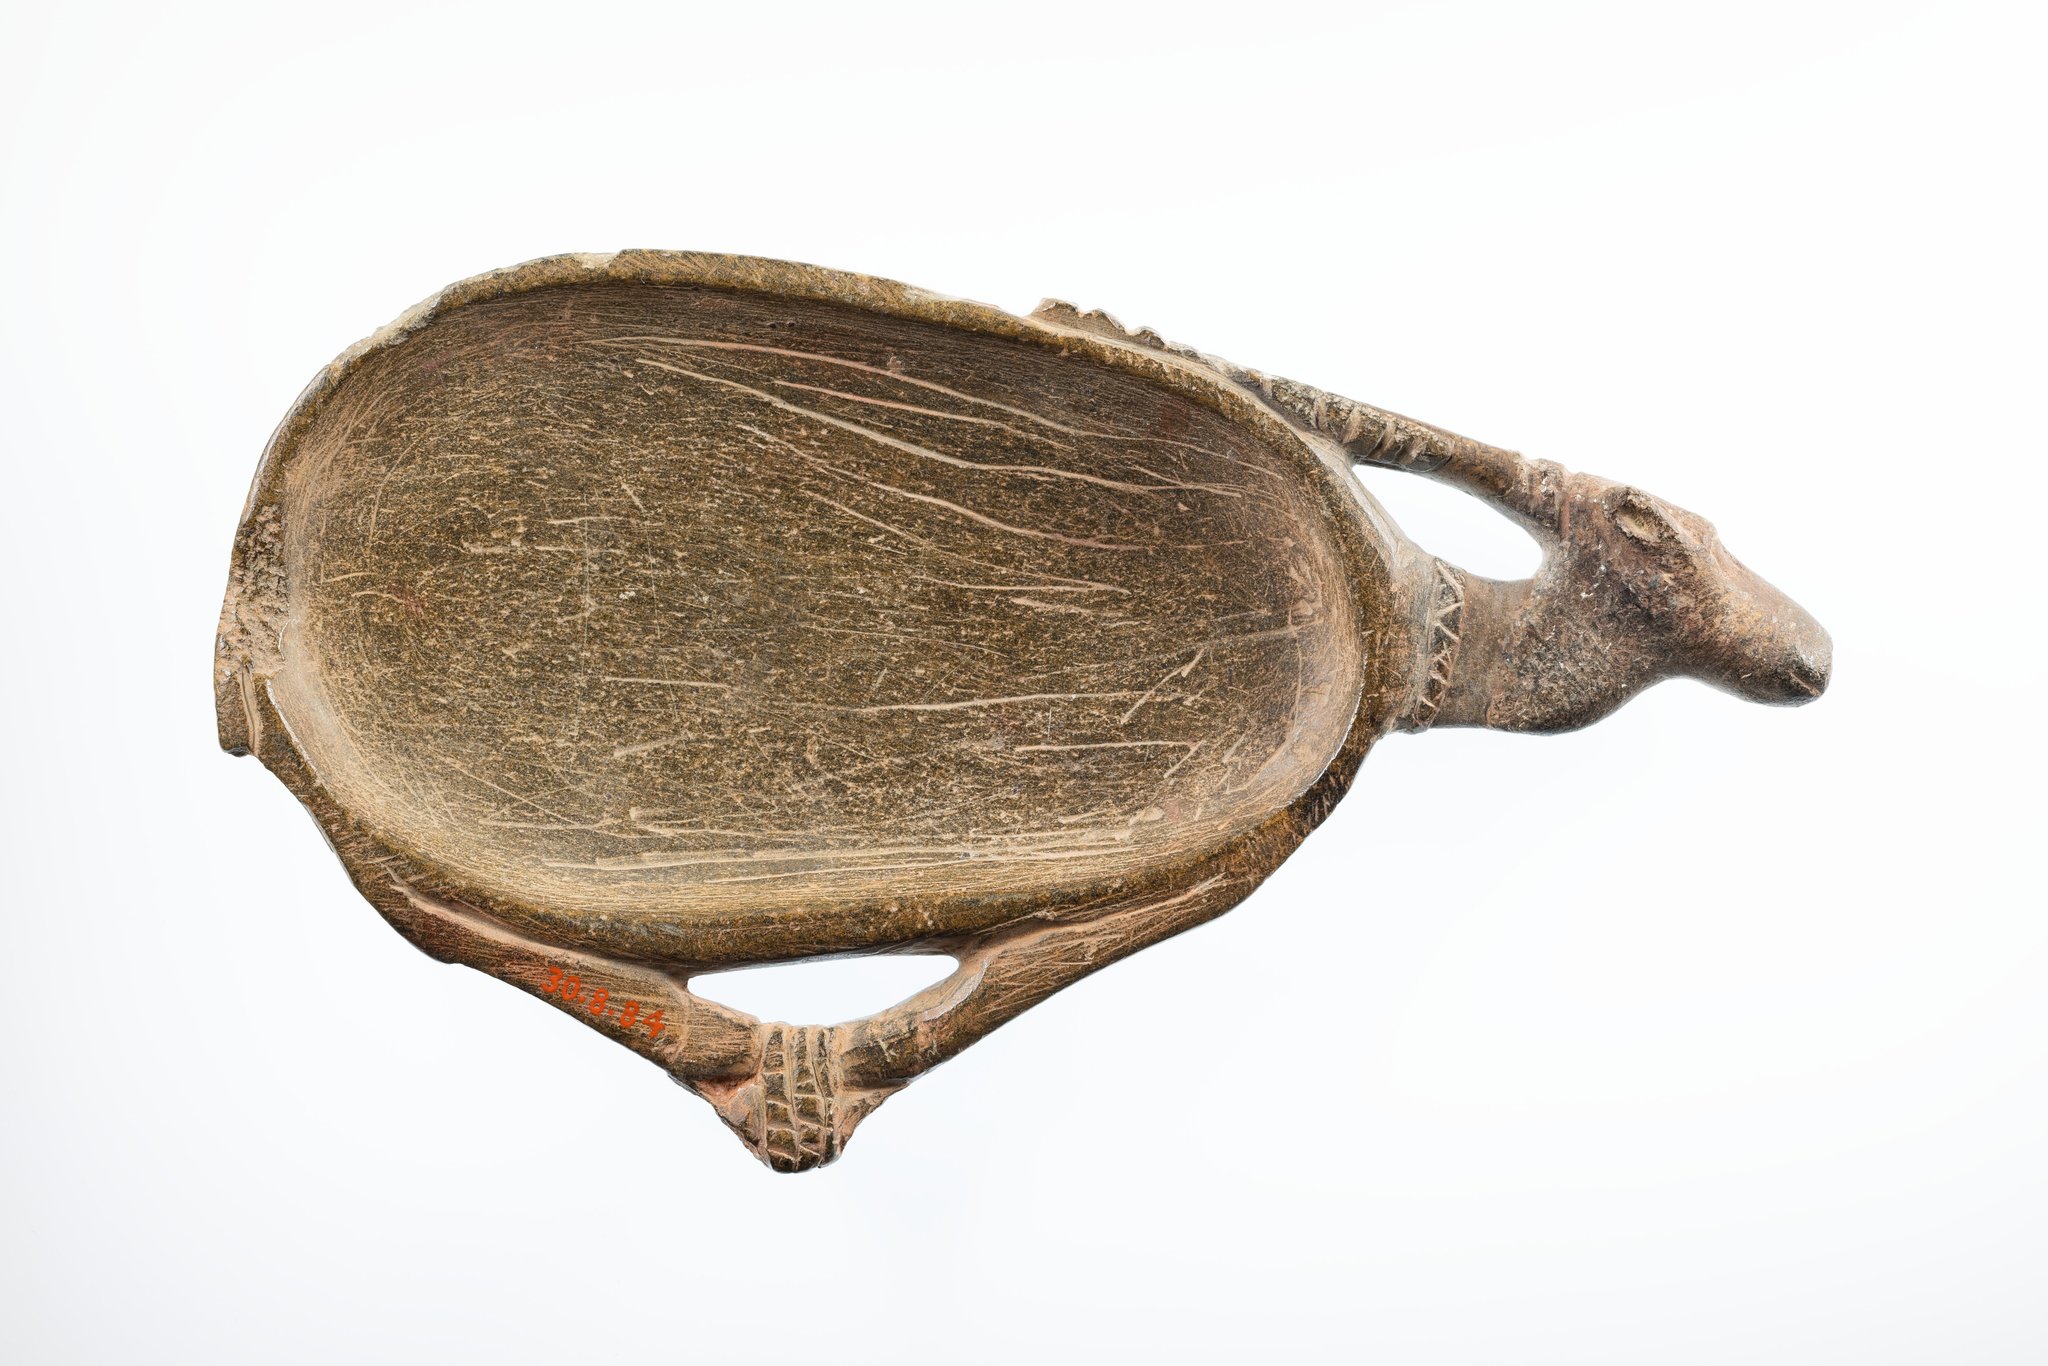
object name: cosmetic dish, bound antelope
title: Cosmetic dish in the shape of a bound antelope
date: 1295-1070 BCE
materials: stone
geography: egypt